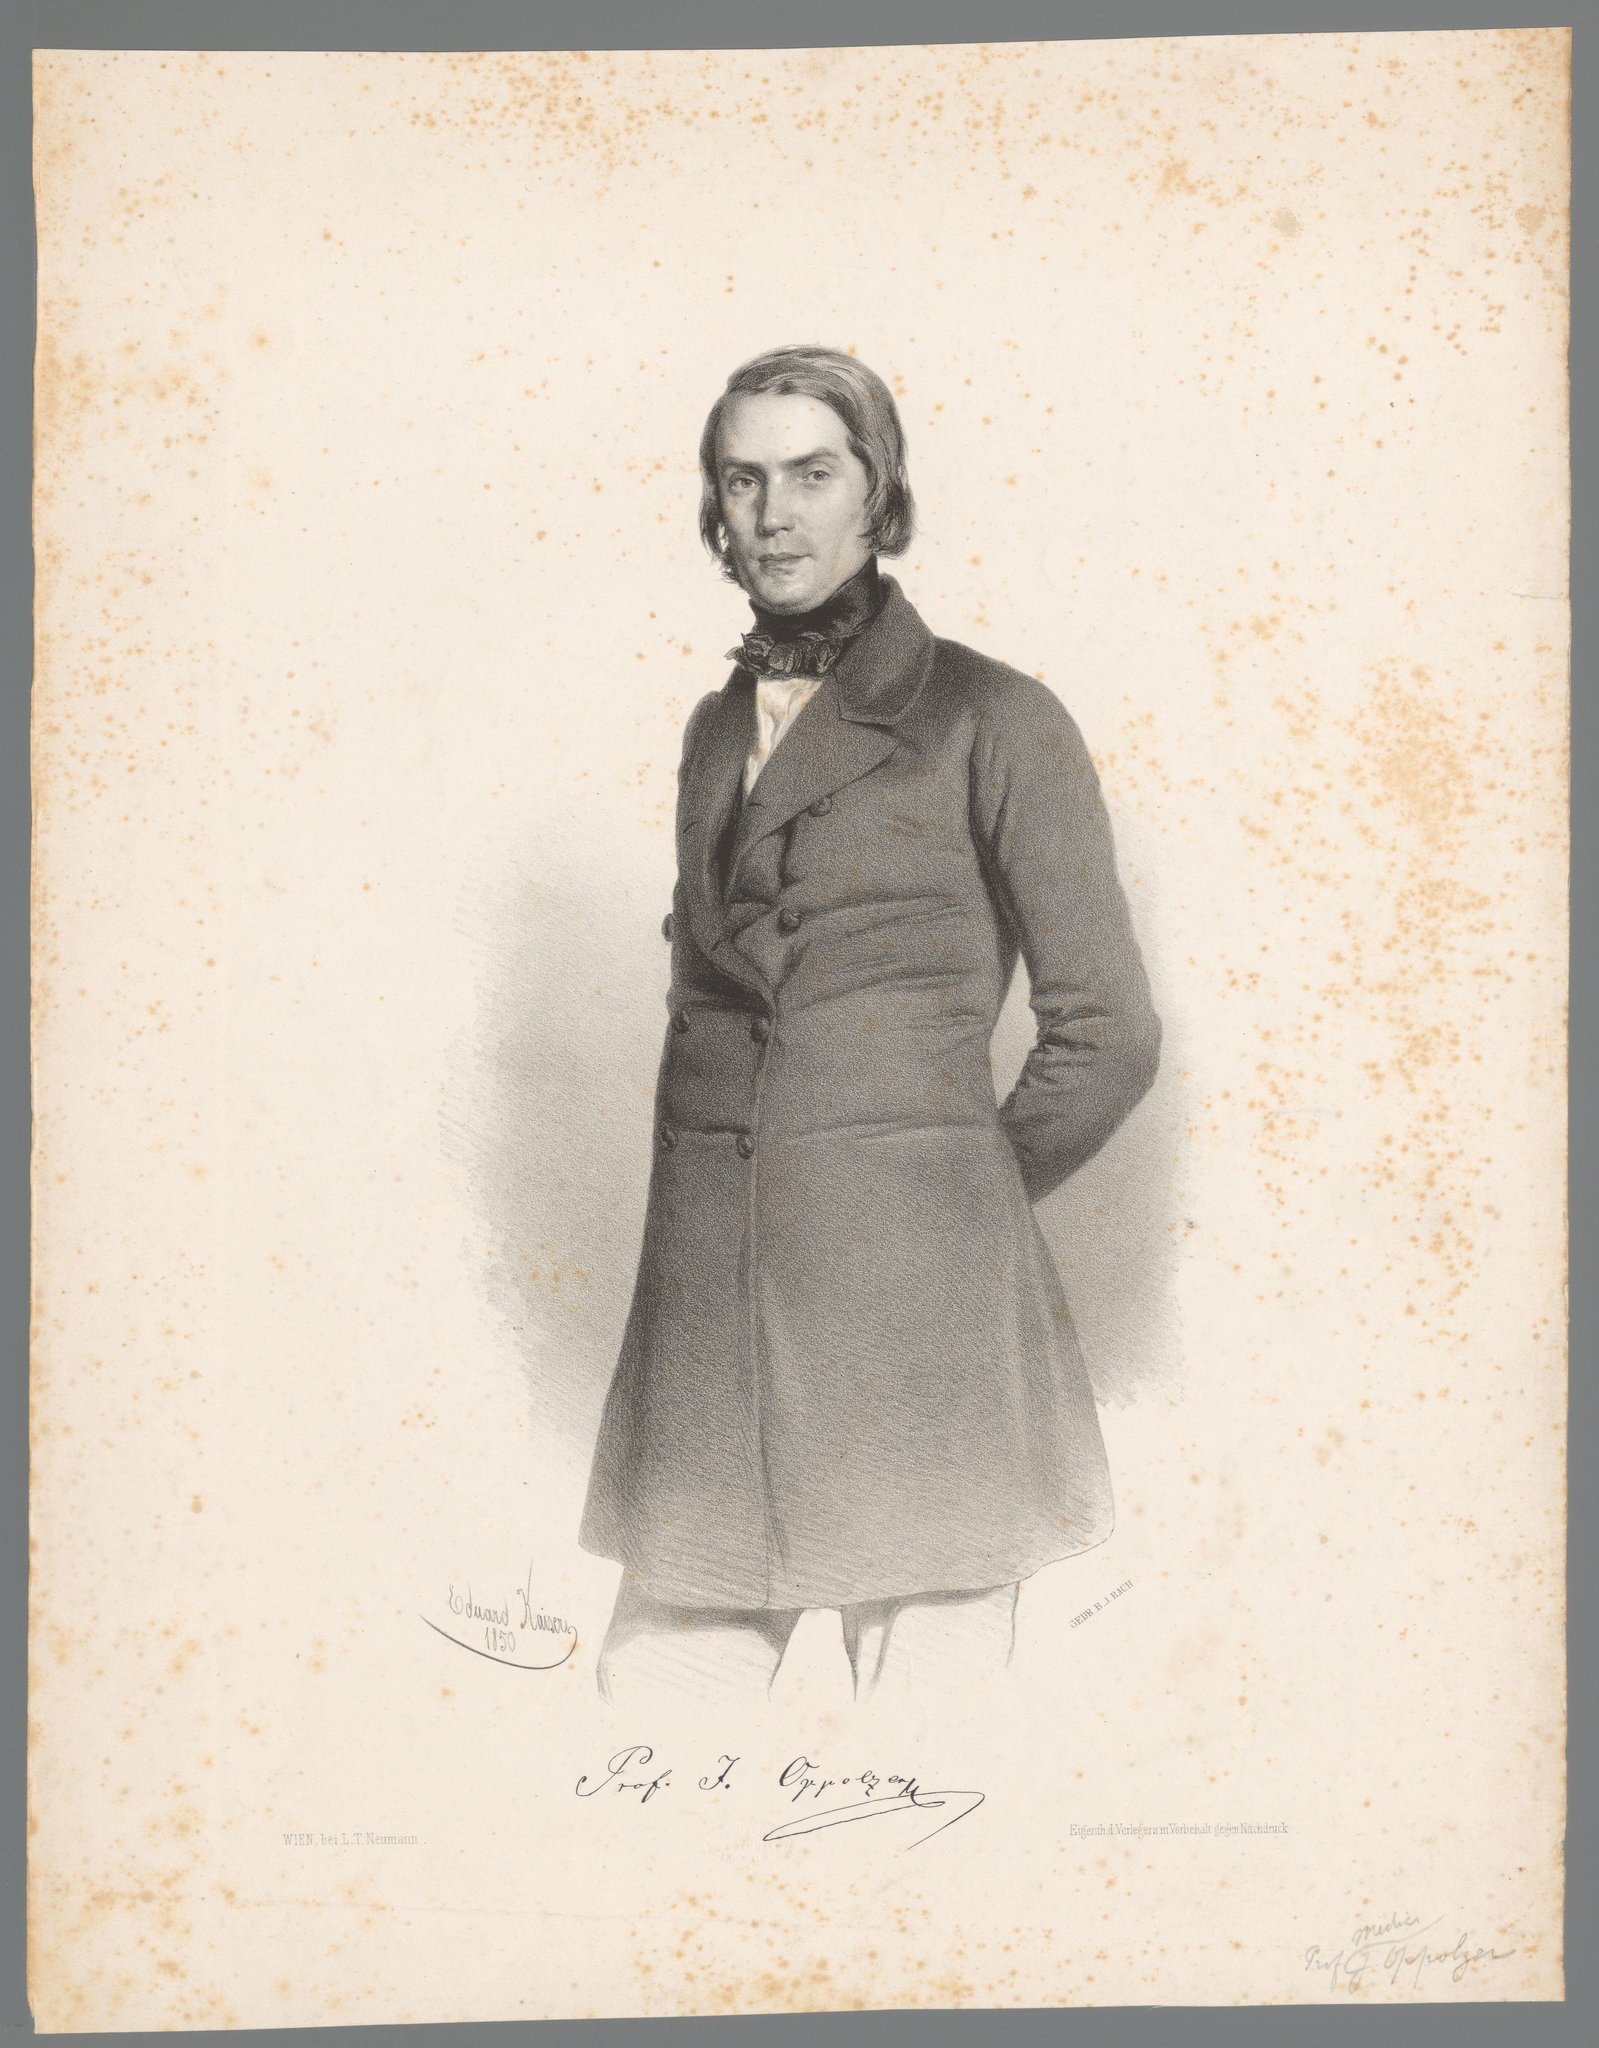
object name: print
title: Portret van Johann Oppolzer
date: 1850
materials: paper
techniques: lithograph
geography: vienna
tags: adult man, historical persons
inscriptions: collector's mark: Lugt 2228, check stamp: ‘Kunsthandlung L.T. Neumann in Wien’